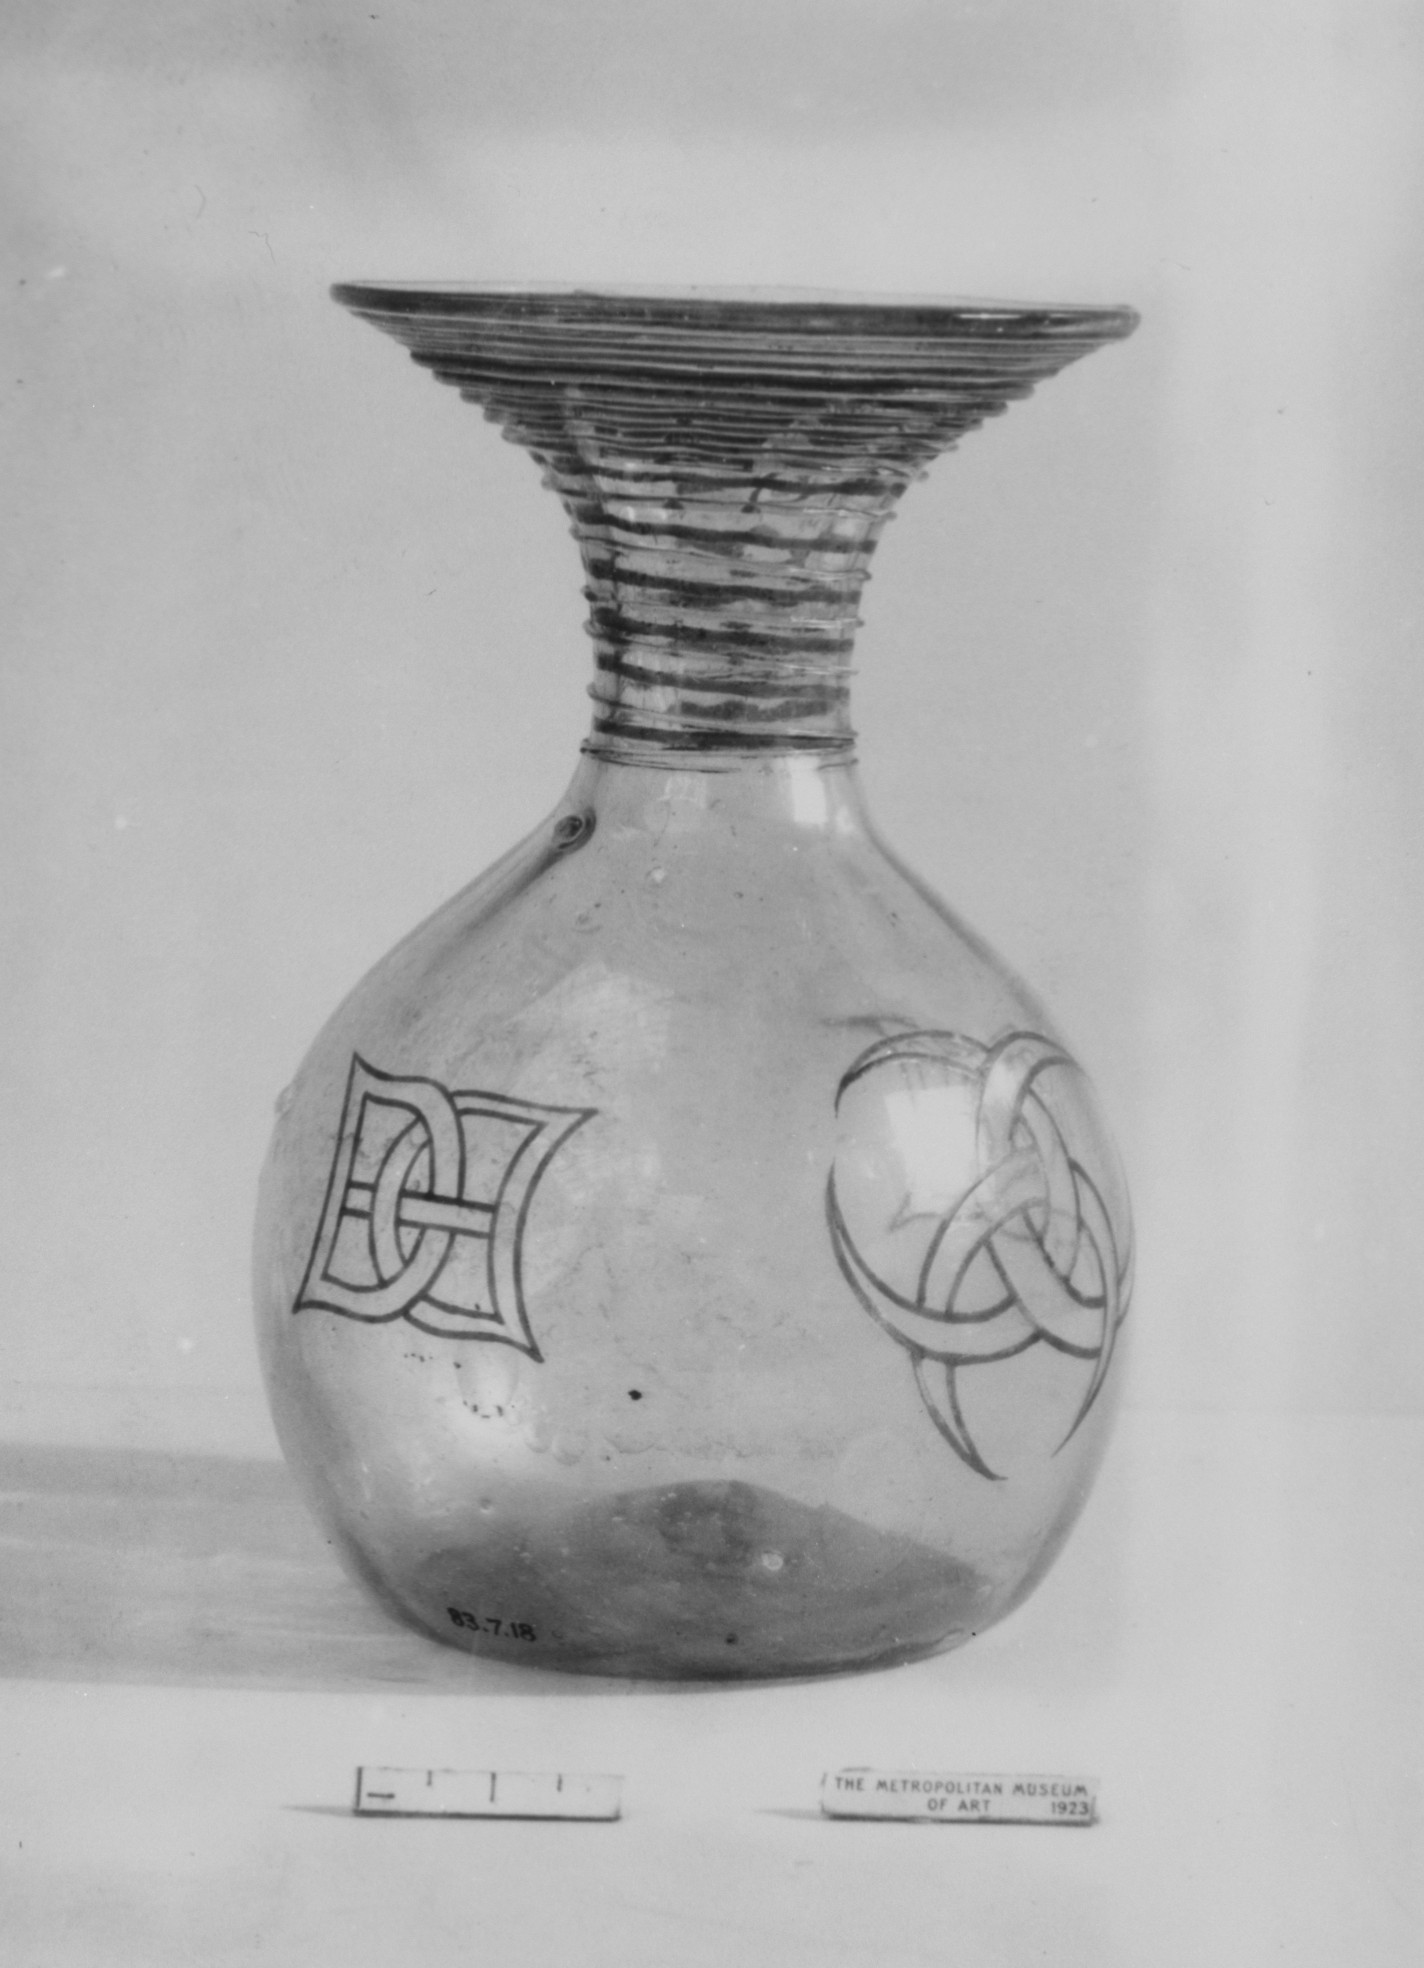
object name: vase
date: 1701-1800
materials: glass